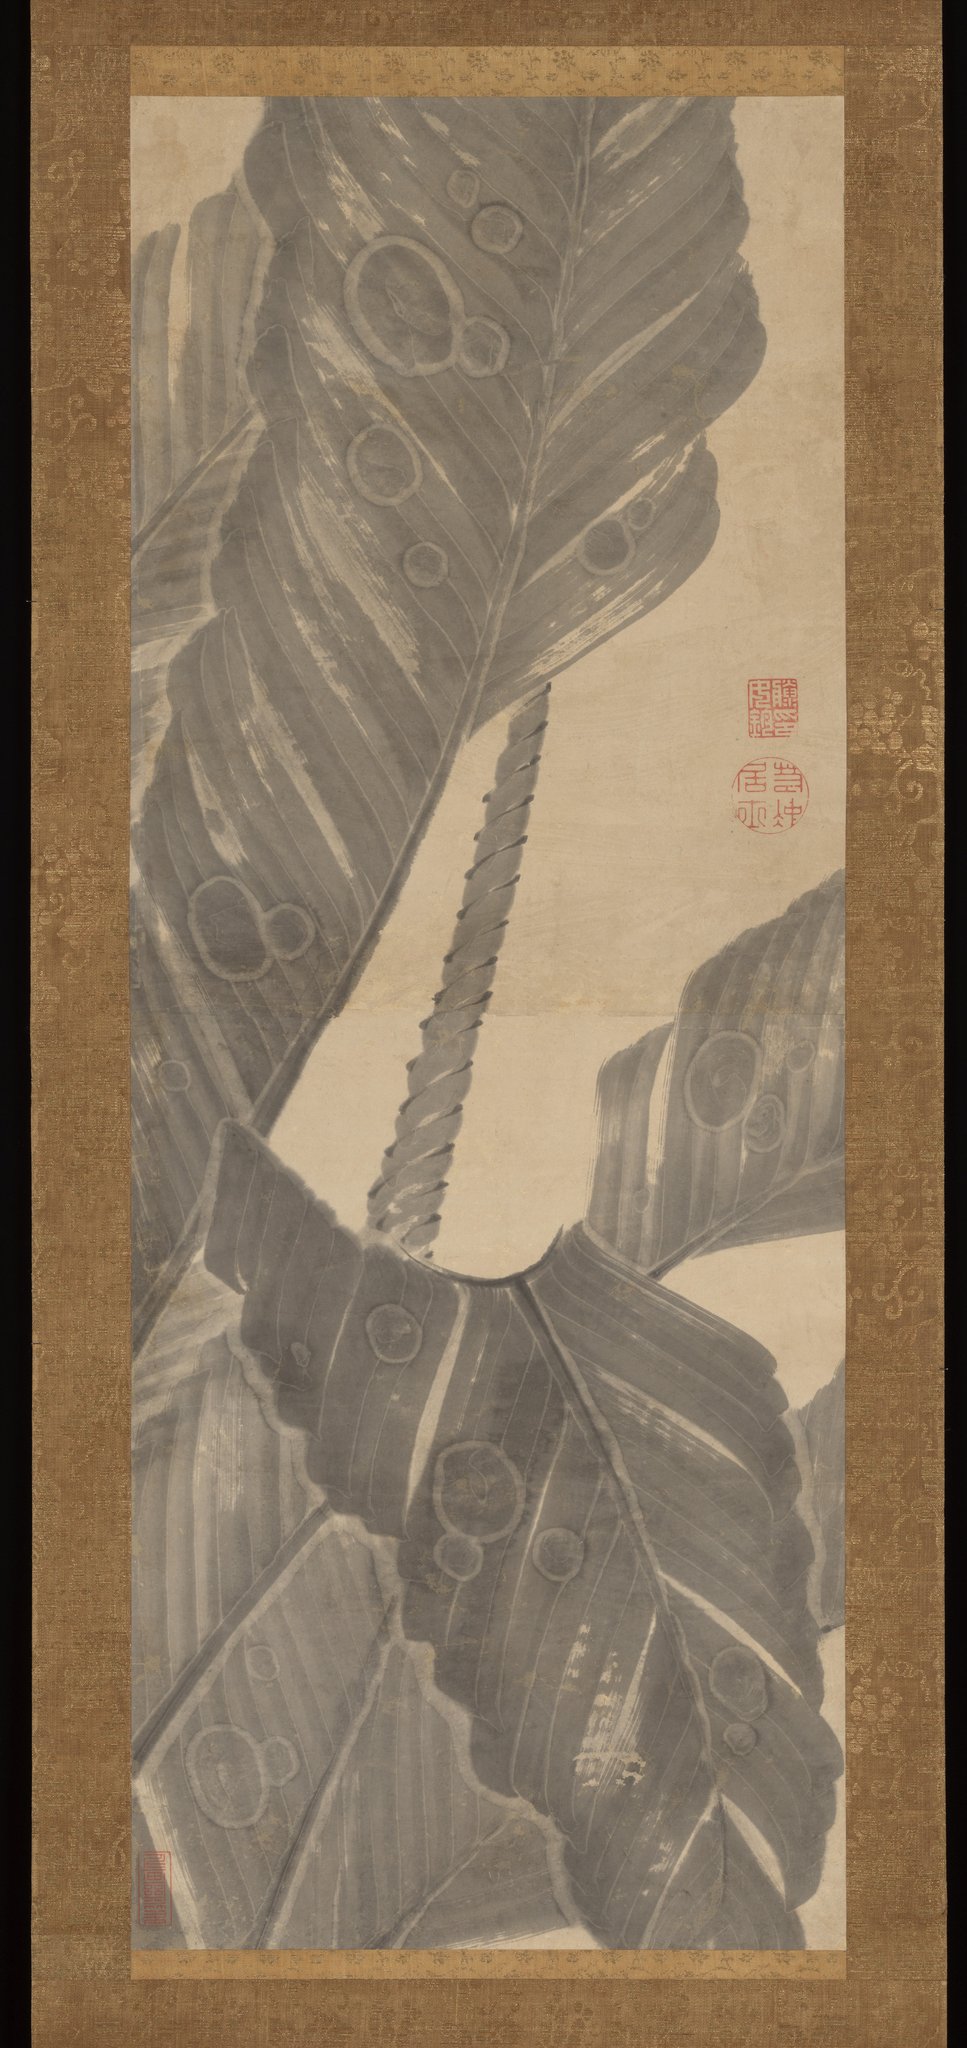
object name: hanging scroll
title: Banana Leaves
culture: japanese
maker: itō jakuchū 伊藤若冲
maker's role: artist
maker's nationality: japanese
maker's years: 1716-1800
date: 1790-1799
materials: ink, paper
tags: leaves